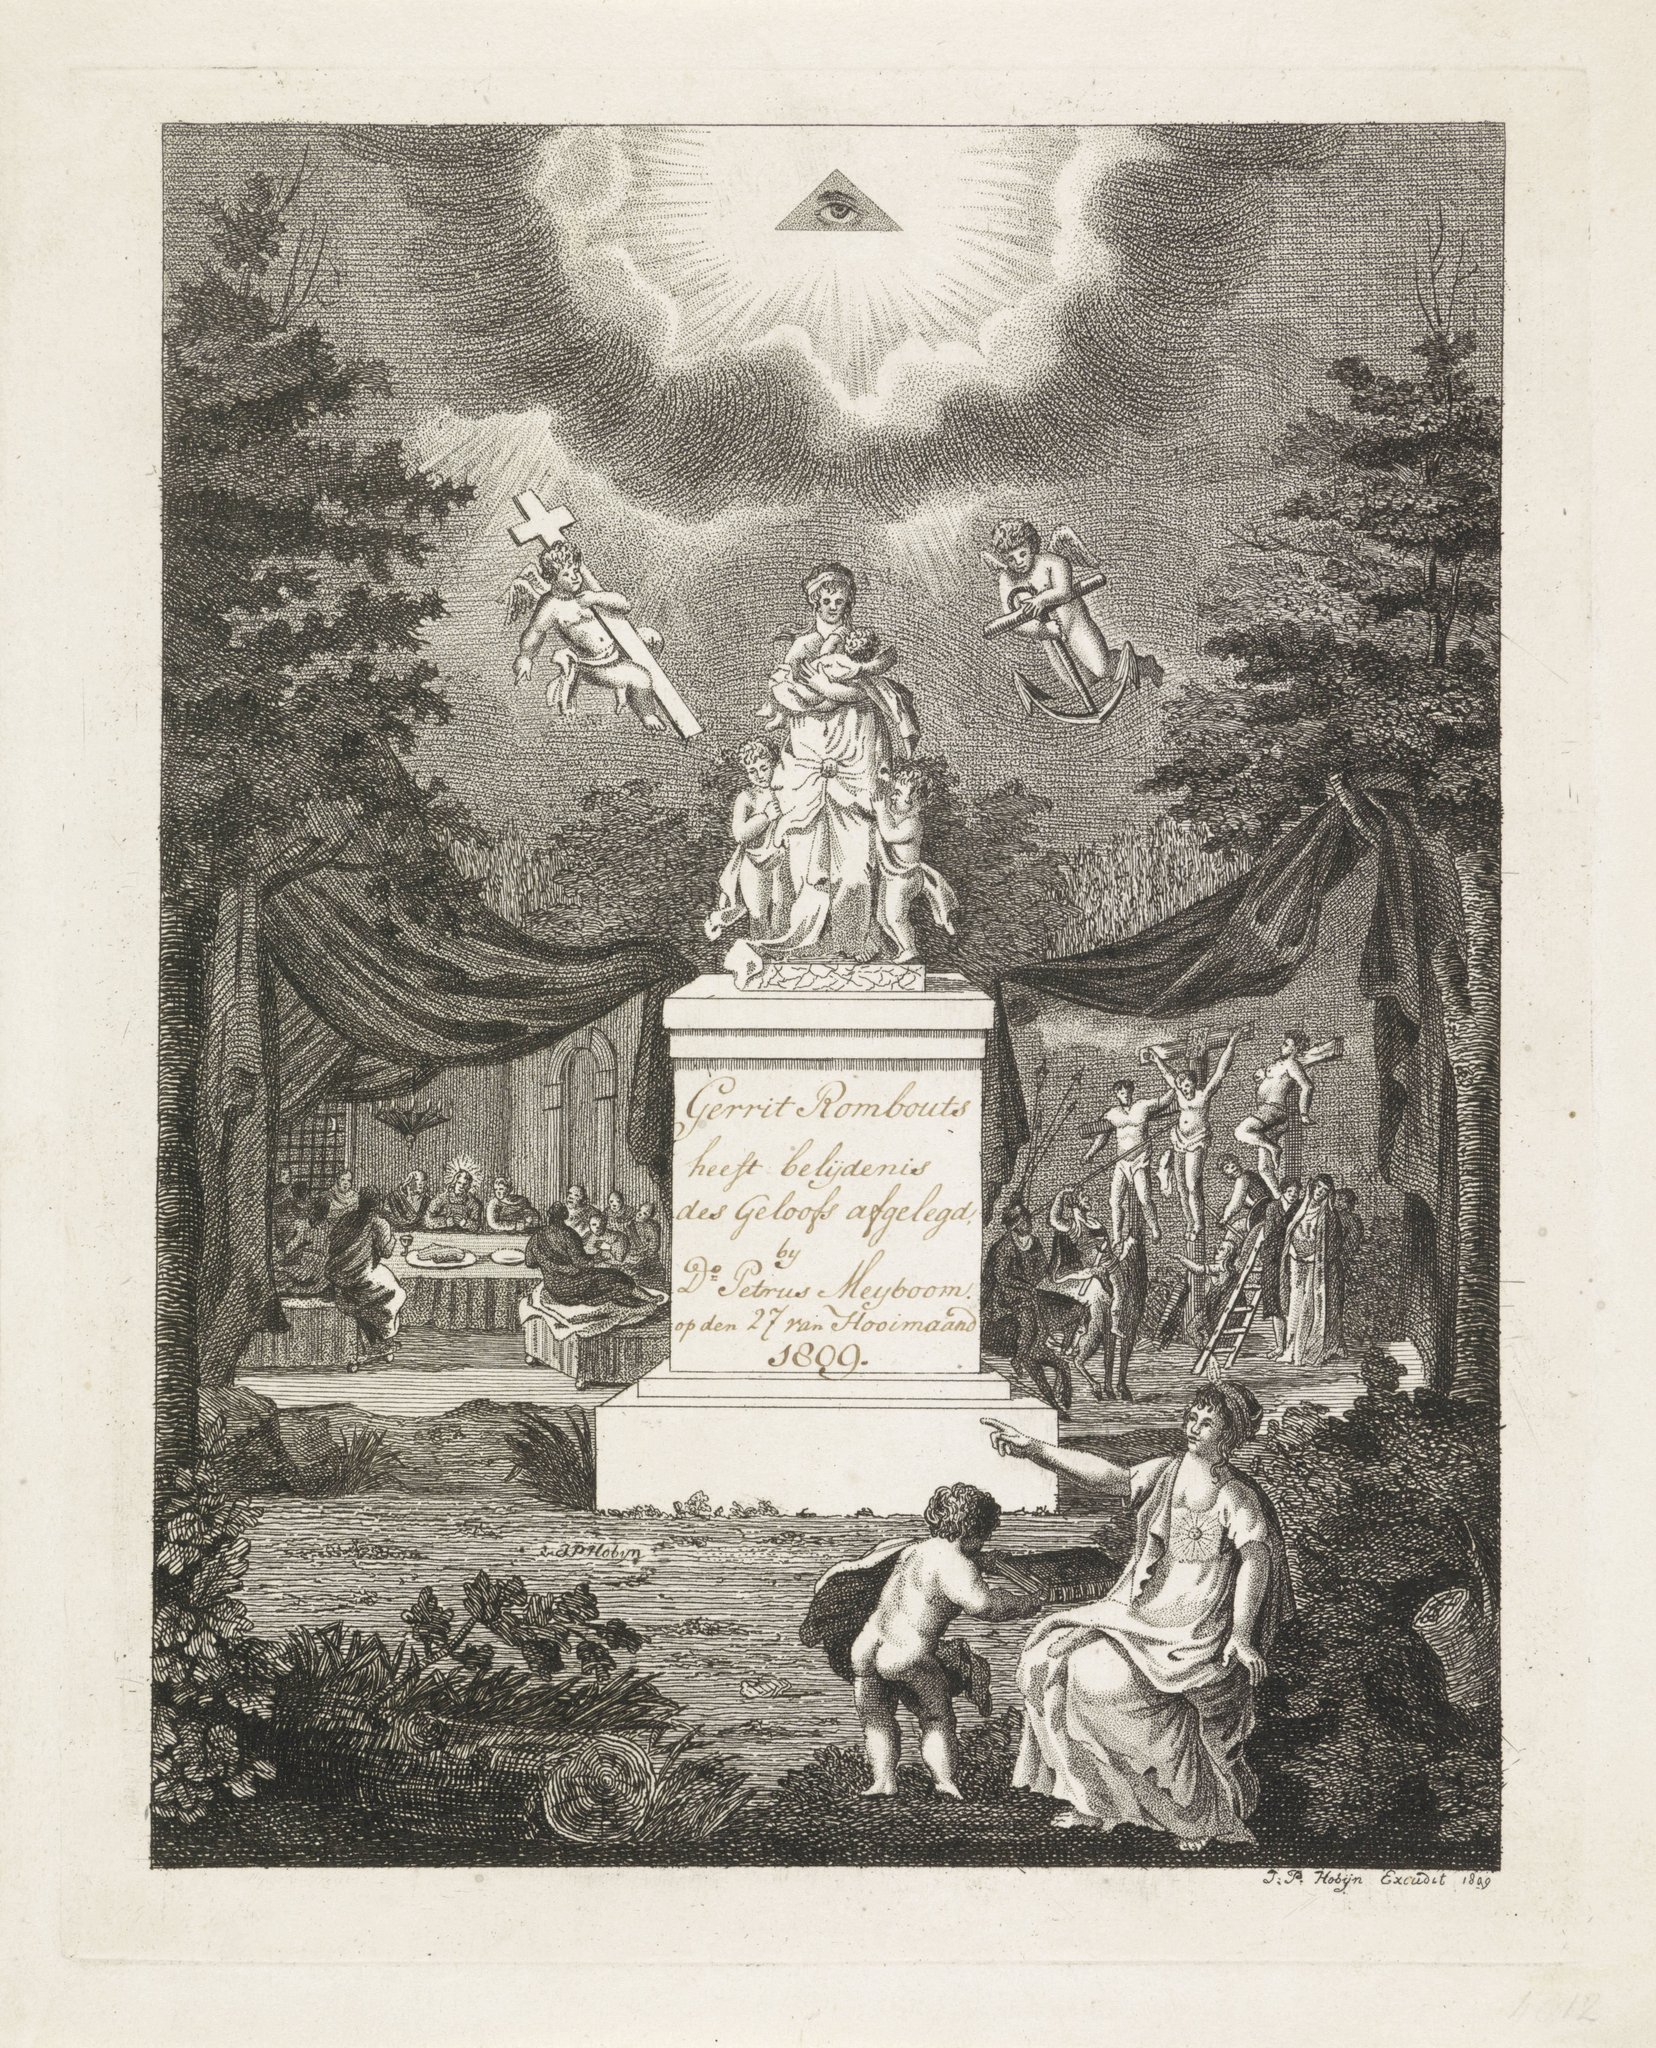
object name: print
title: Belijdenisprent van Gerrit Rombouts, 1809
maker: j.p. hobijn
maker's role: publisher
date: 1809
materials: paper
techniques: engraving, etching, writing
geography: netherlands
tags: the episode of the last supper, charity, 'caritas'; 'carità' (ripa) ~ one of the three theological virtues, the crucifixion of christ: christ's death on the cross; golgotha (matthew 27:45-58; mark 15:33-45; luke 23:44-52; john 19:25-38)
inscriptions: collector's mark: Lugt 2228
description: Prent uitgereikt aan jonge lidmaten van de Hervormde kerk na het afleggen van hun geloofsbelijdenis. Monument met een standbeeld van de Liefde. Links het Laatste Avondmaal, rechts de kruisiging. Op het voetstuk is met pen geschreven de naam van Gerrit Rombouts en de datum van zijn belijdenis, 27 juli 1809, afgelegd bij ds. Petrus Meijboom.